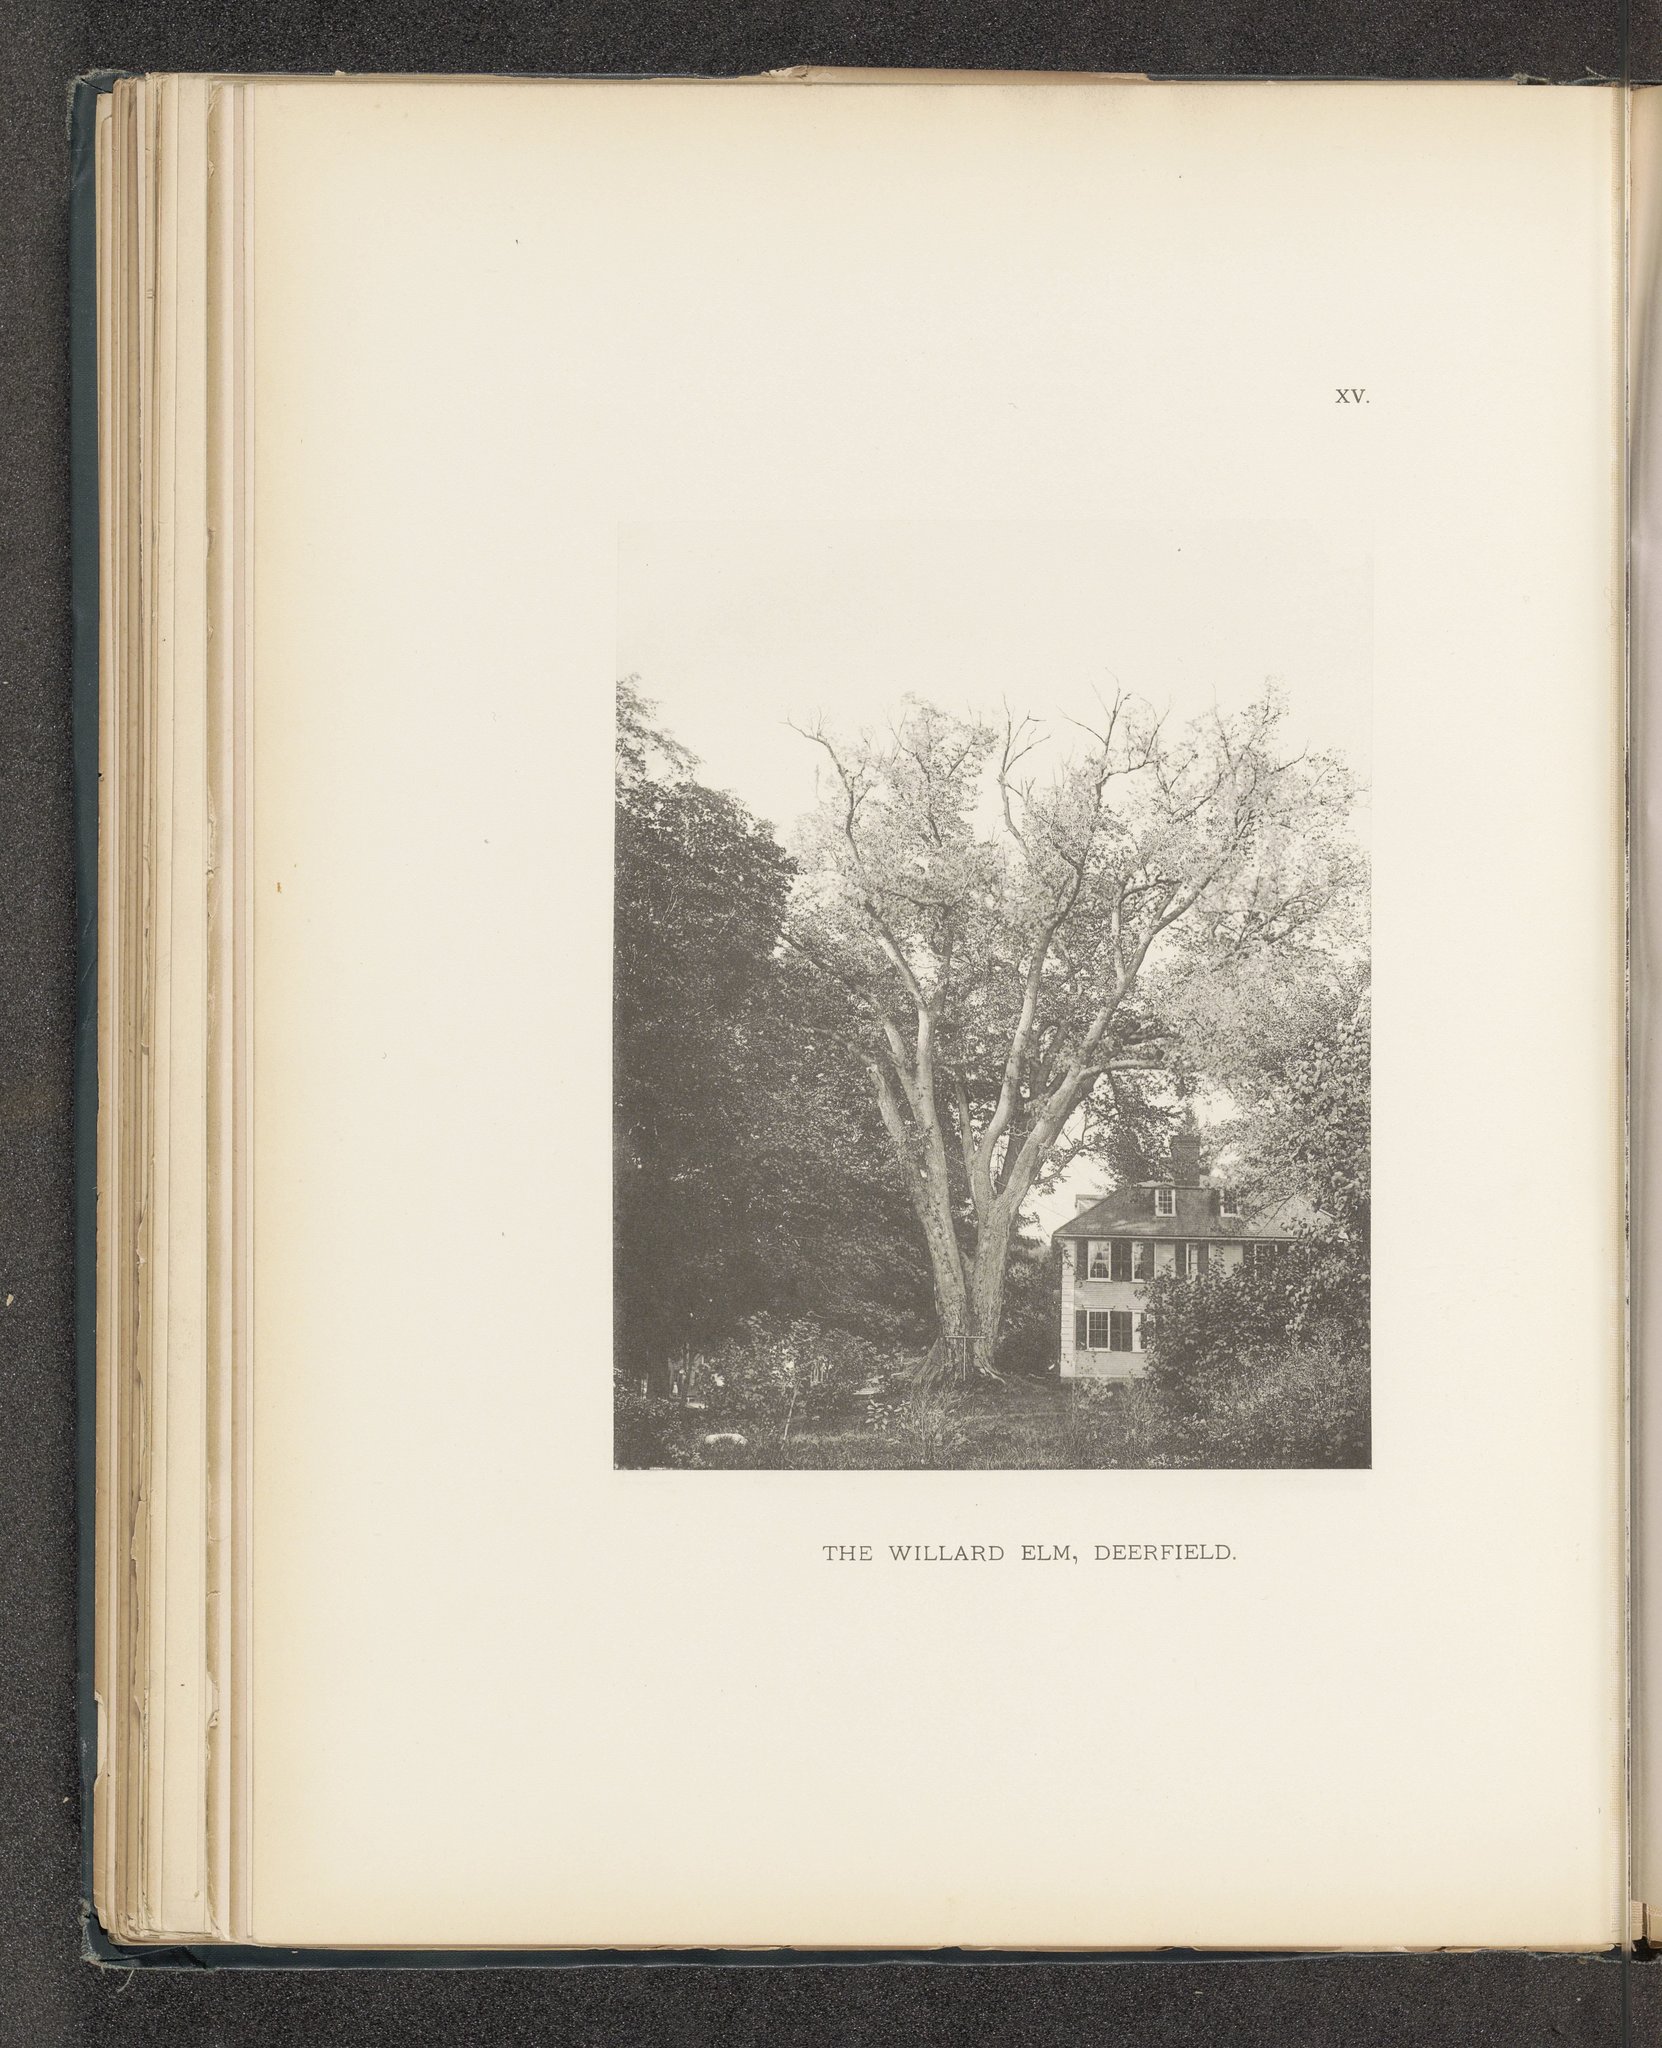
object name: photomechanical print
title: The Willard elm, Deerfield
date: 1880-1890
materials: paper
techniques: photograph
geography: united states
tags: trees: elm, façade (of house or building)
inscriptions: number: ‘XV.’